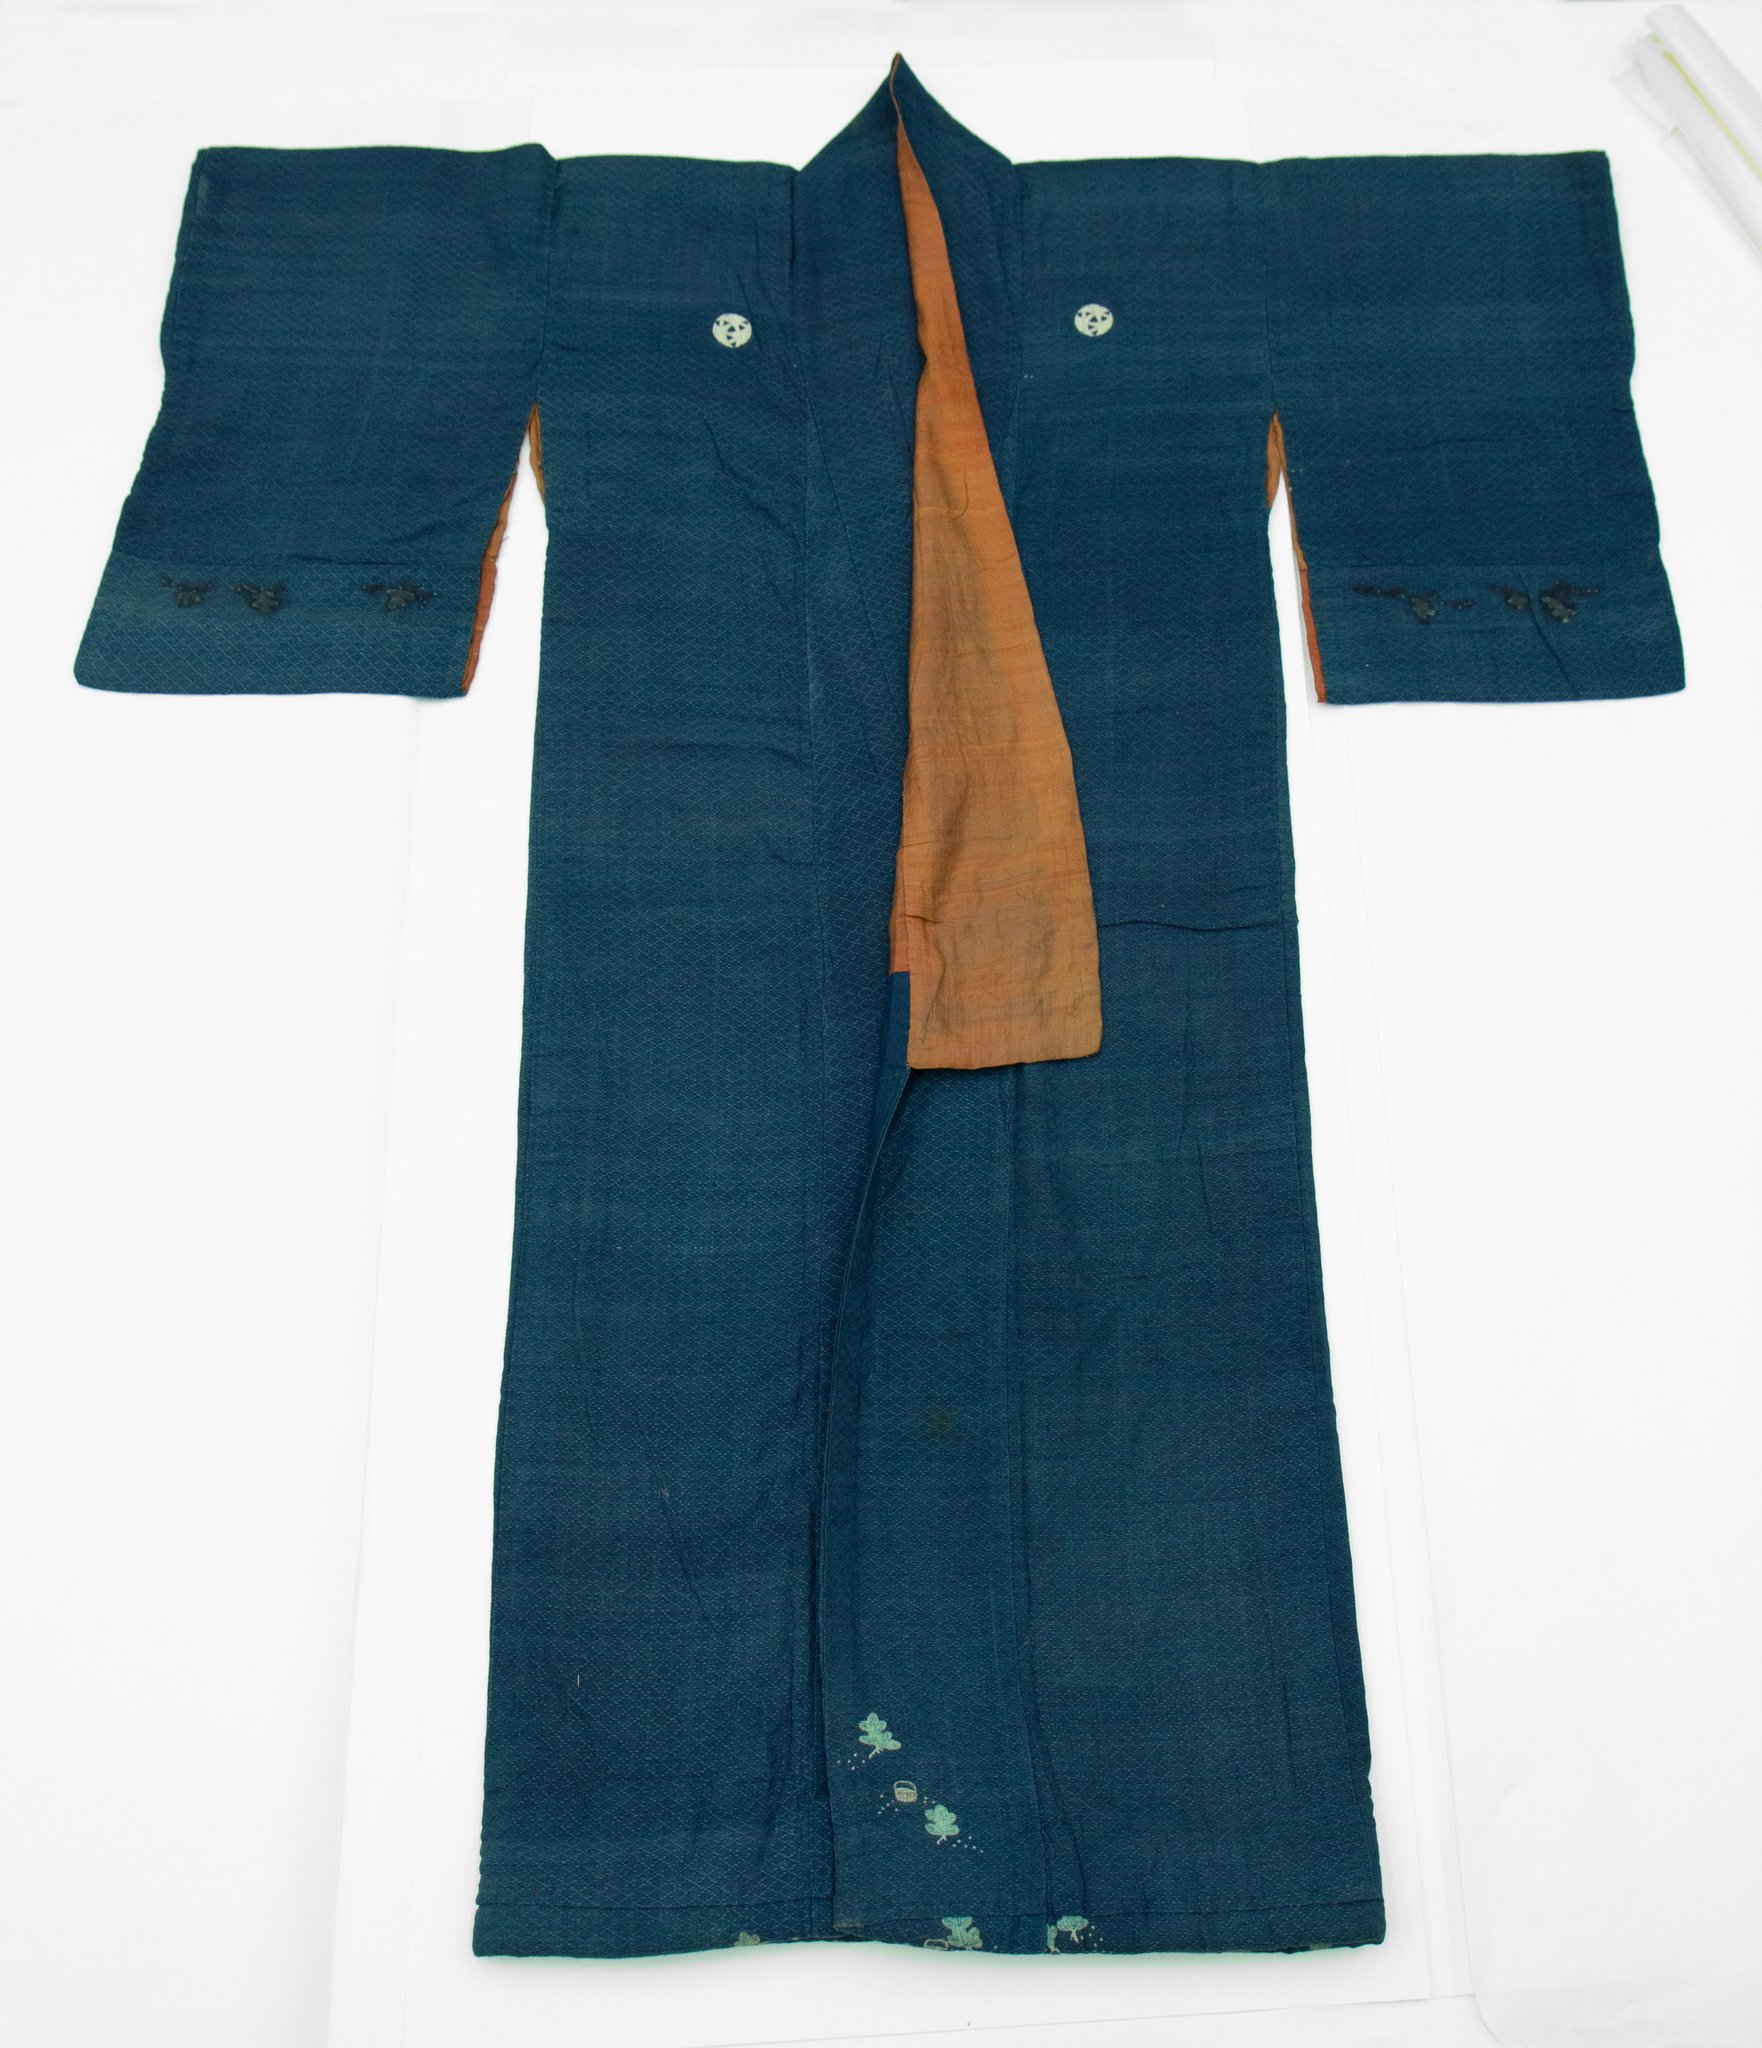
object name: kosode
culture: japanese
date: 1615-1868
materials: bamboo